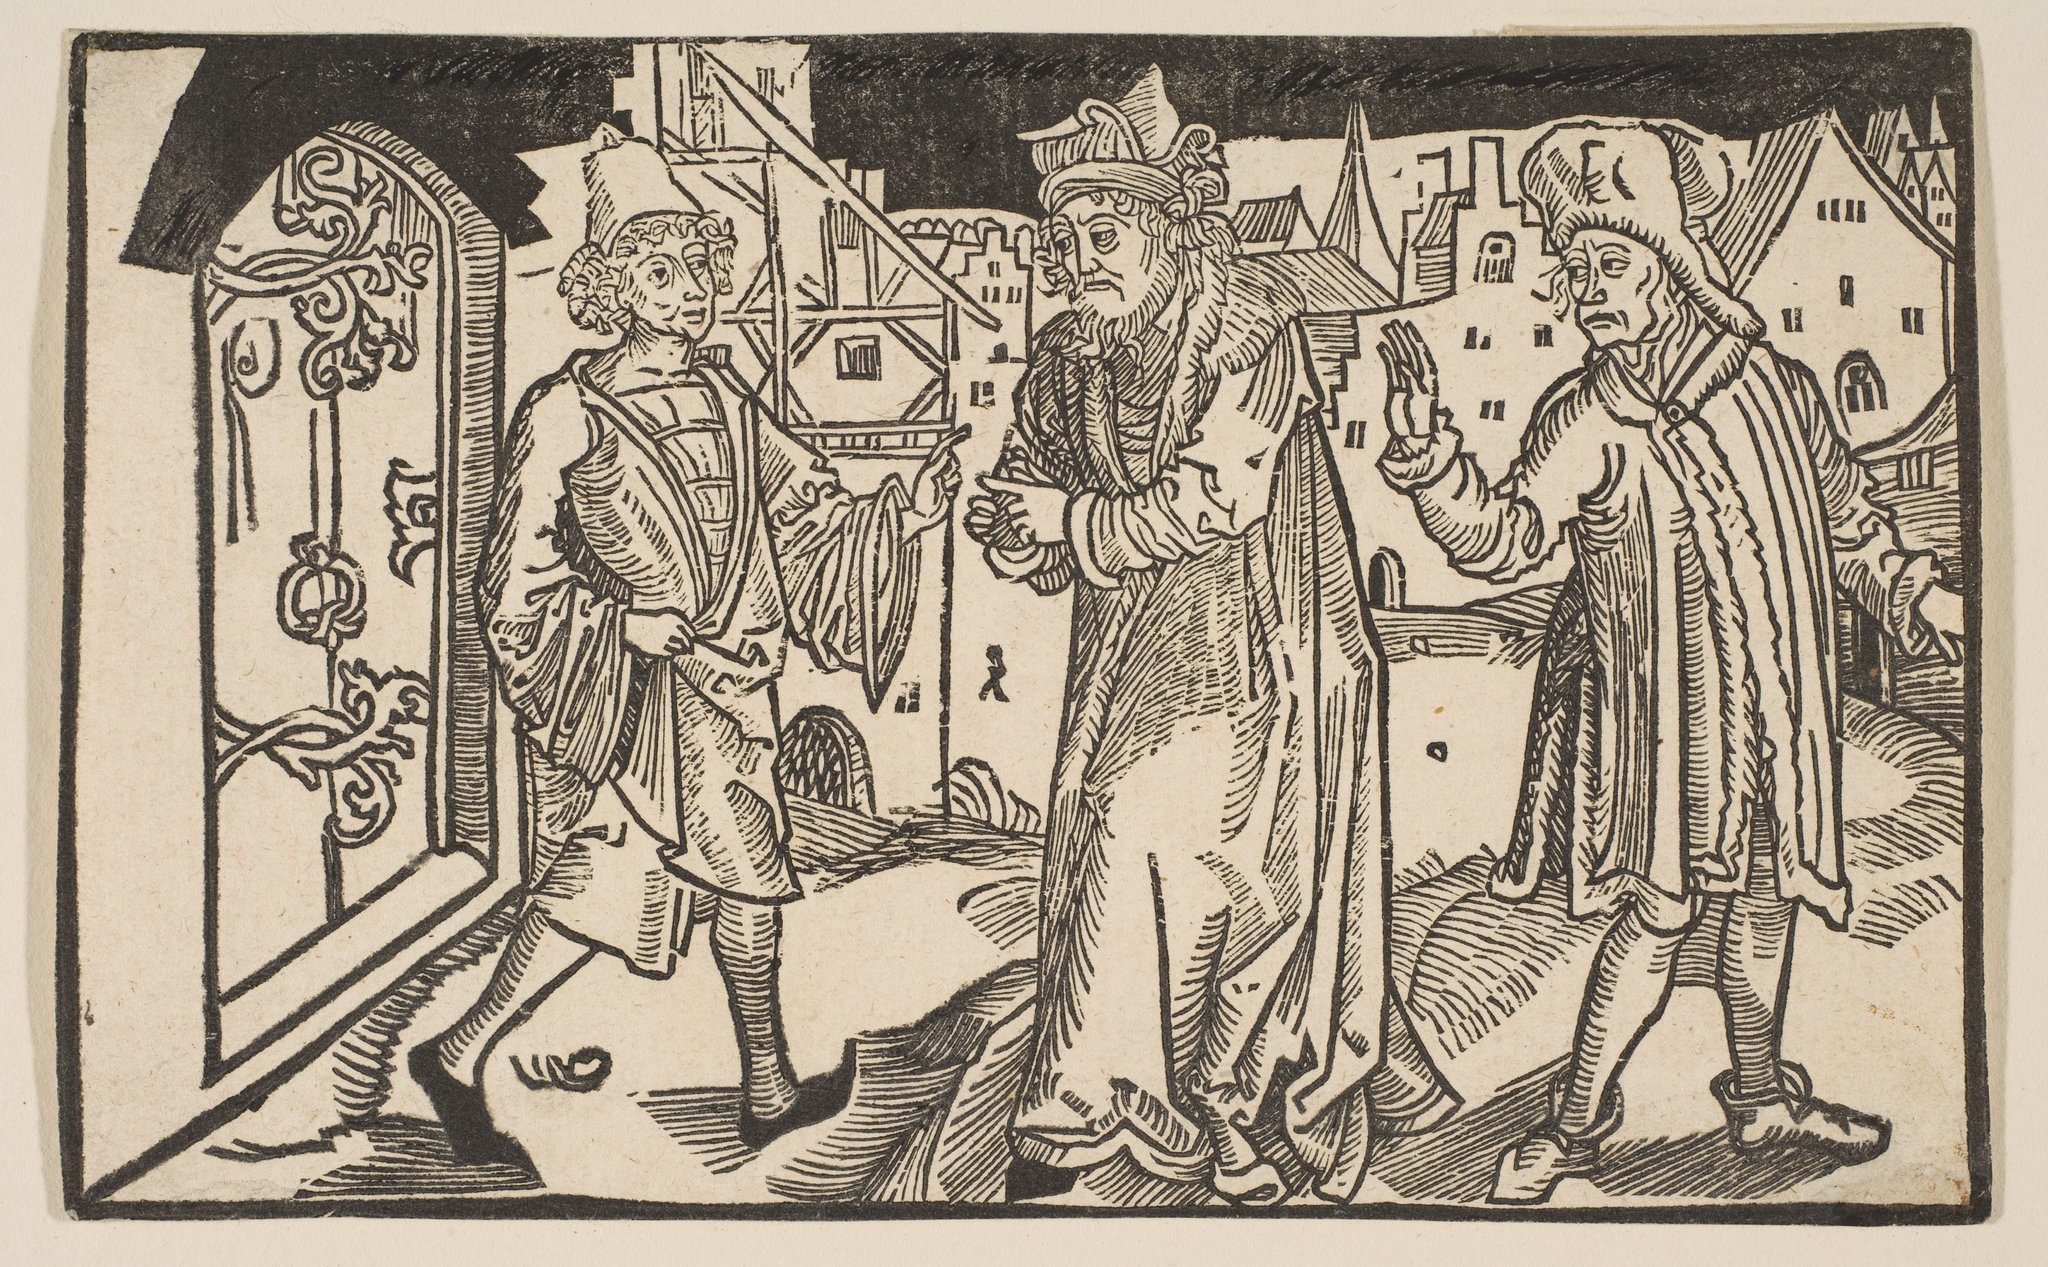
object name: print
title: Andria, from "The Comedie of Terence", 19th century reprint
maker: albrecht dürer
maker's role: artist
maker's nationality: german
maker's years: 1471-1528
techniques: woodcut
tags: human figures